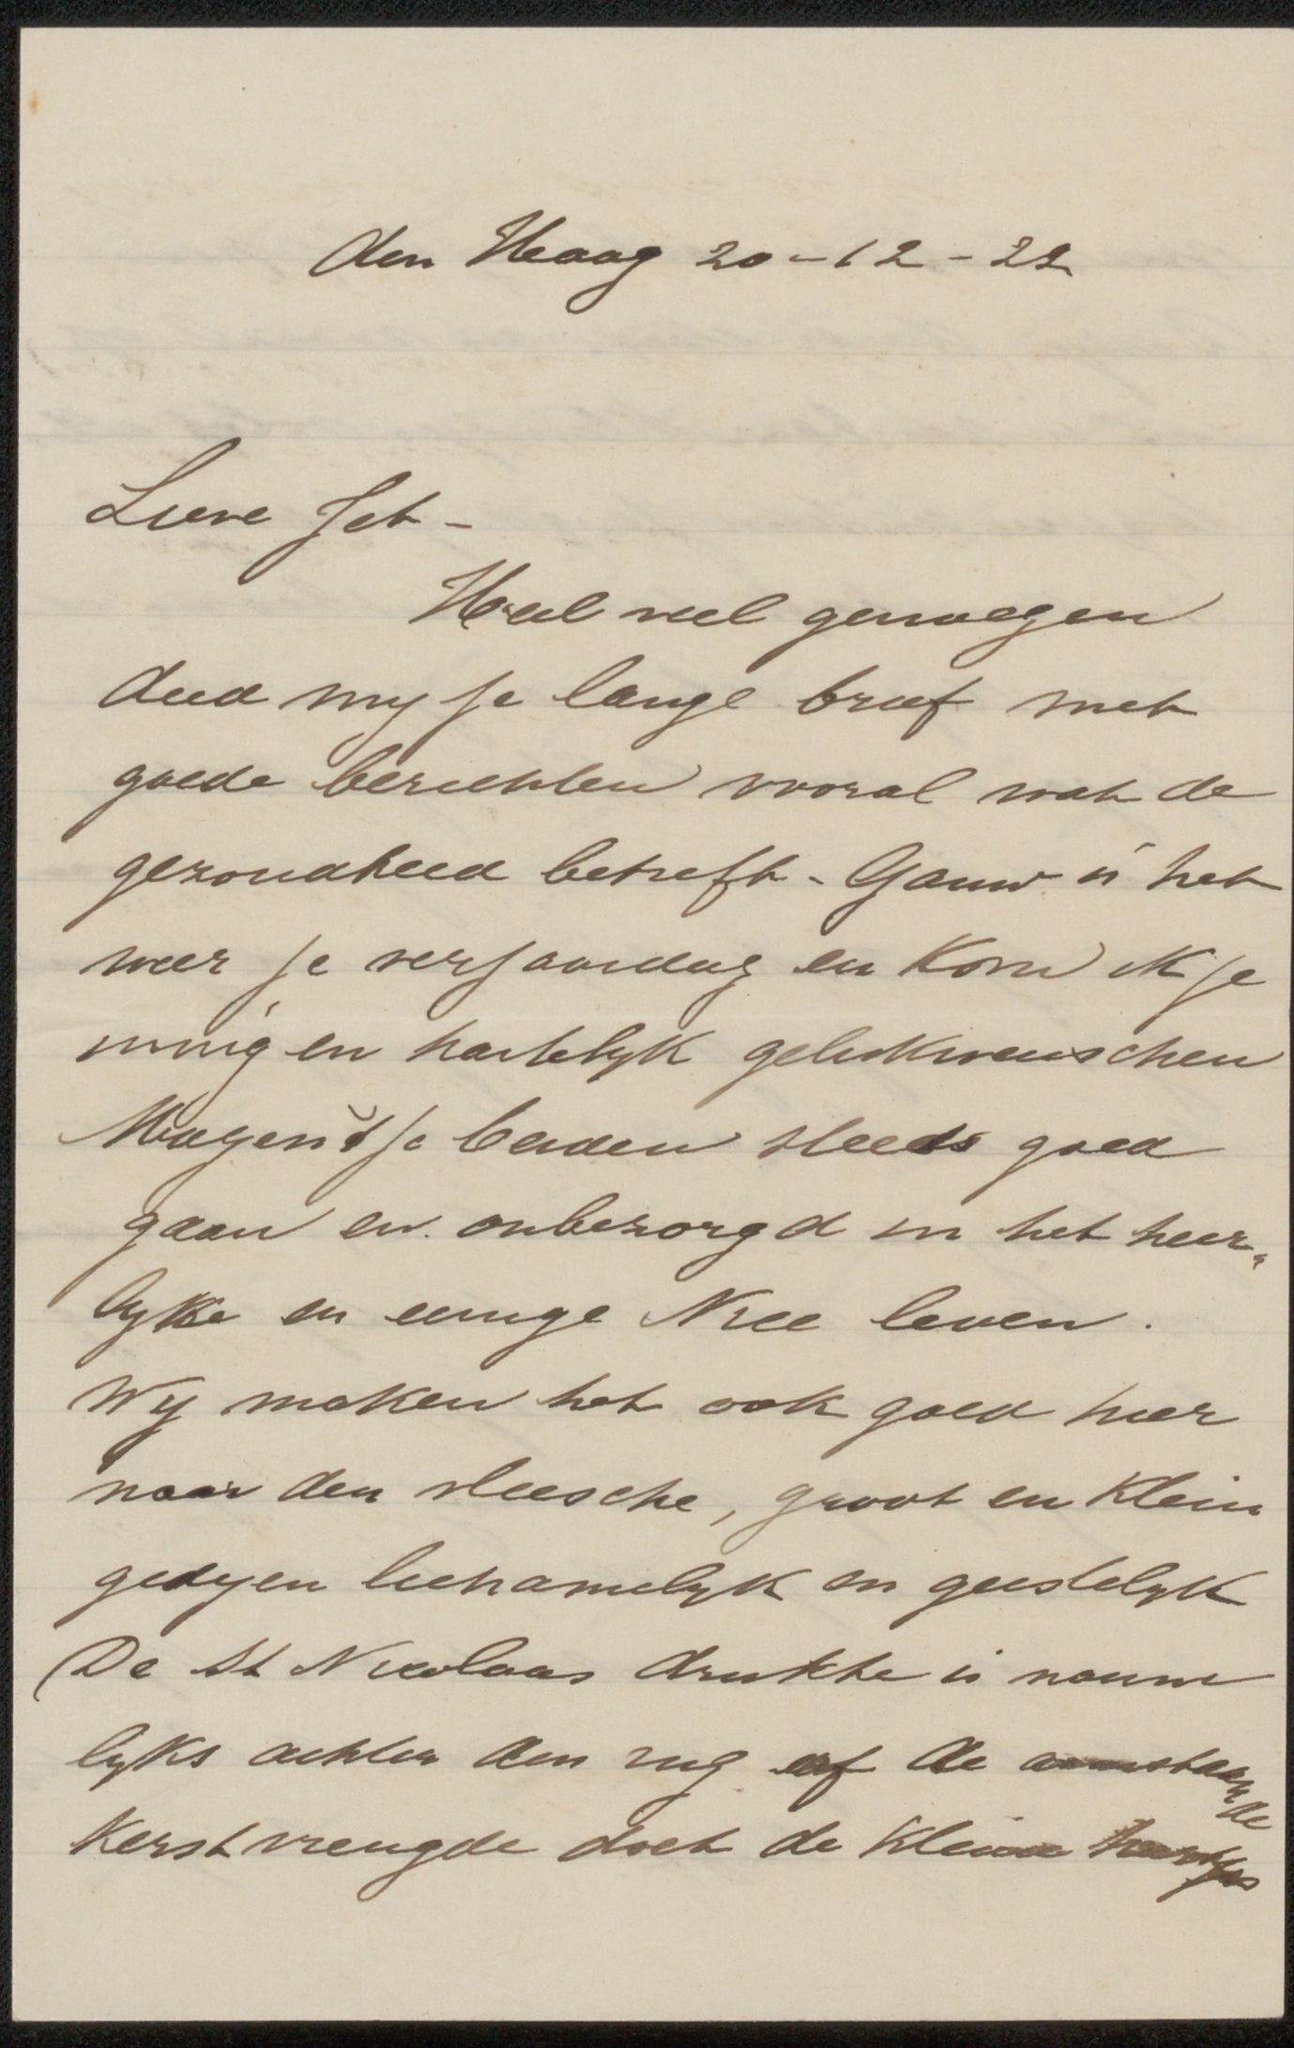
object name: letter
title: Brief aan Henriette Wilhelmina van Baak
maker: Anonymous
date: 1922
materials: ink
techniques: pen, writing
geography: the hague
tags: henriette wilhelmina van baak, family life, money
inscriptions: collector's mark: ‘RPK’